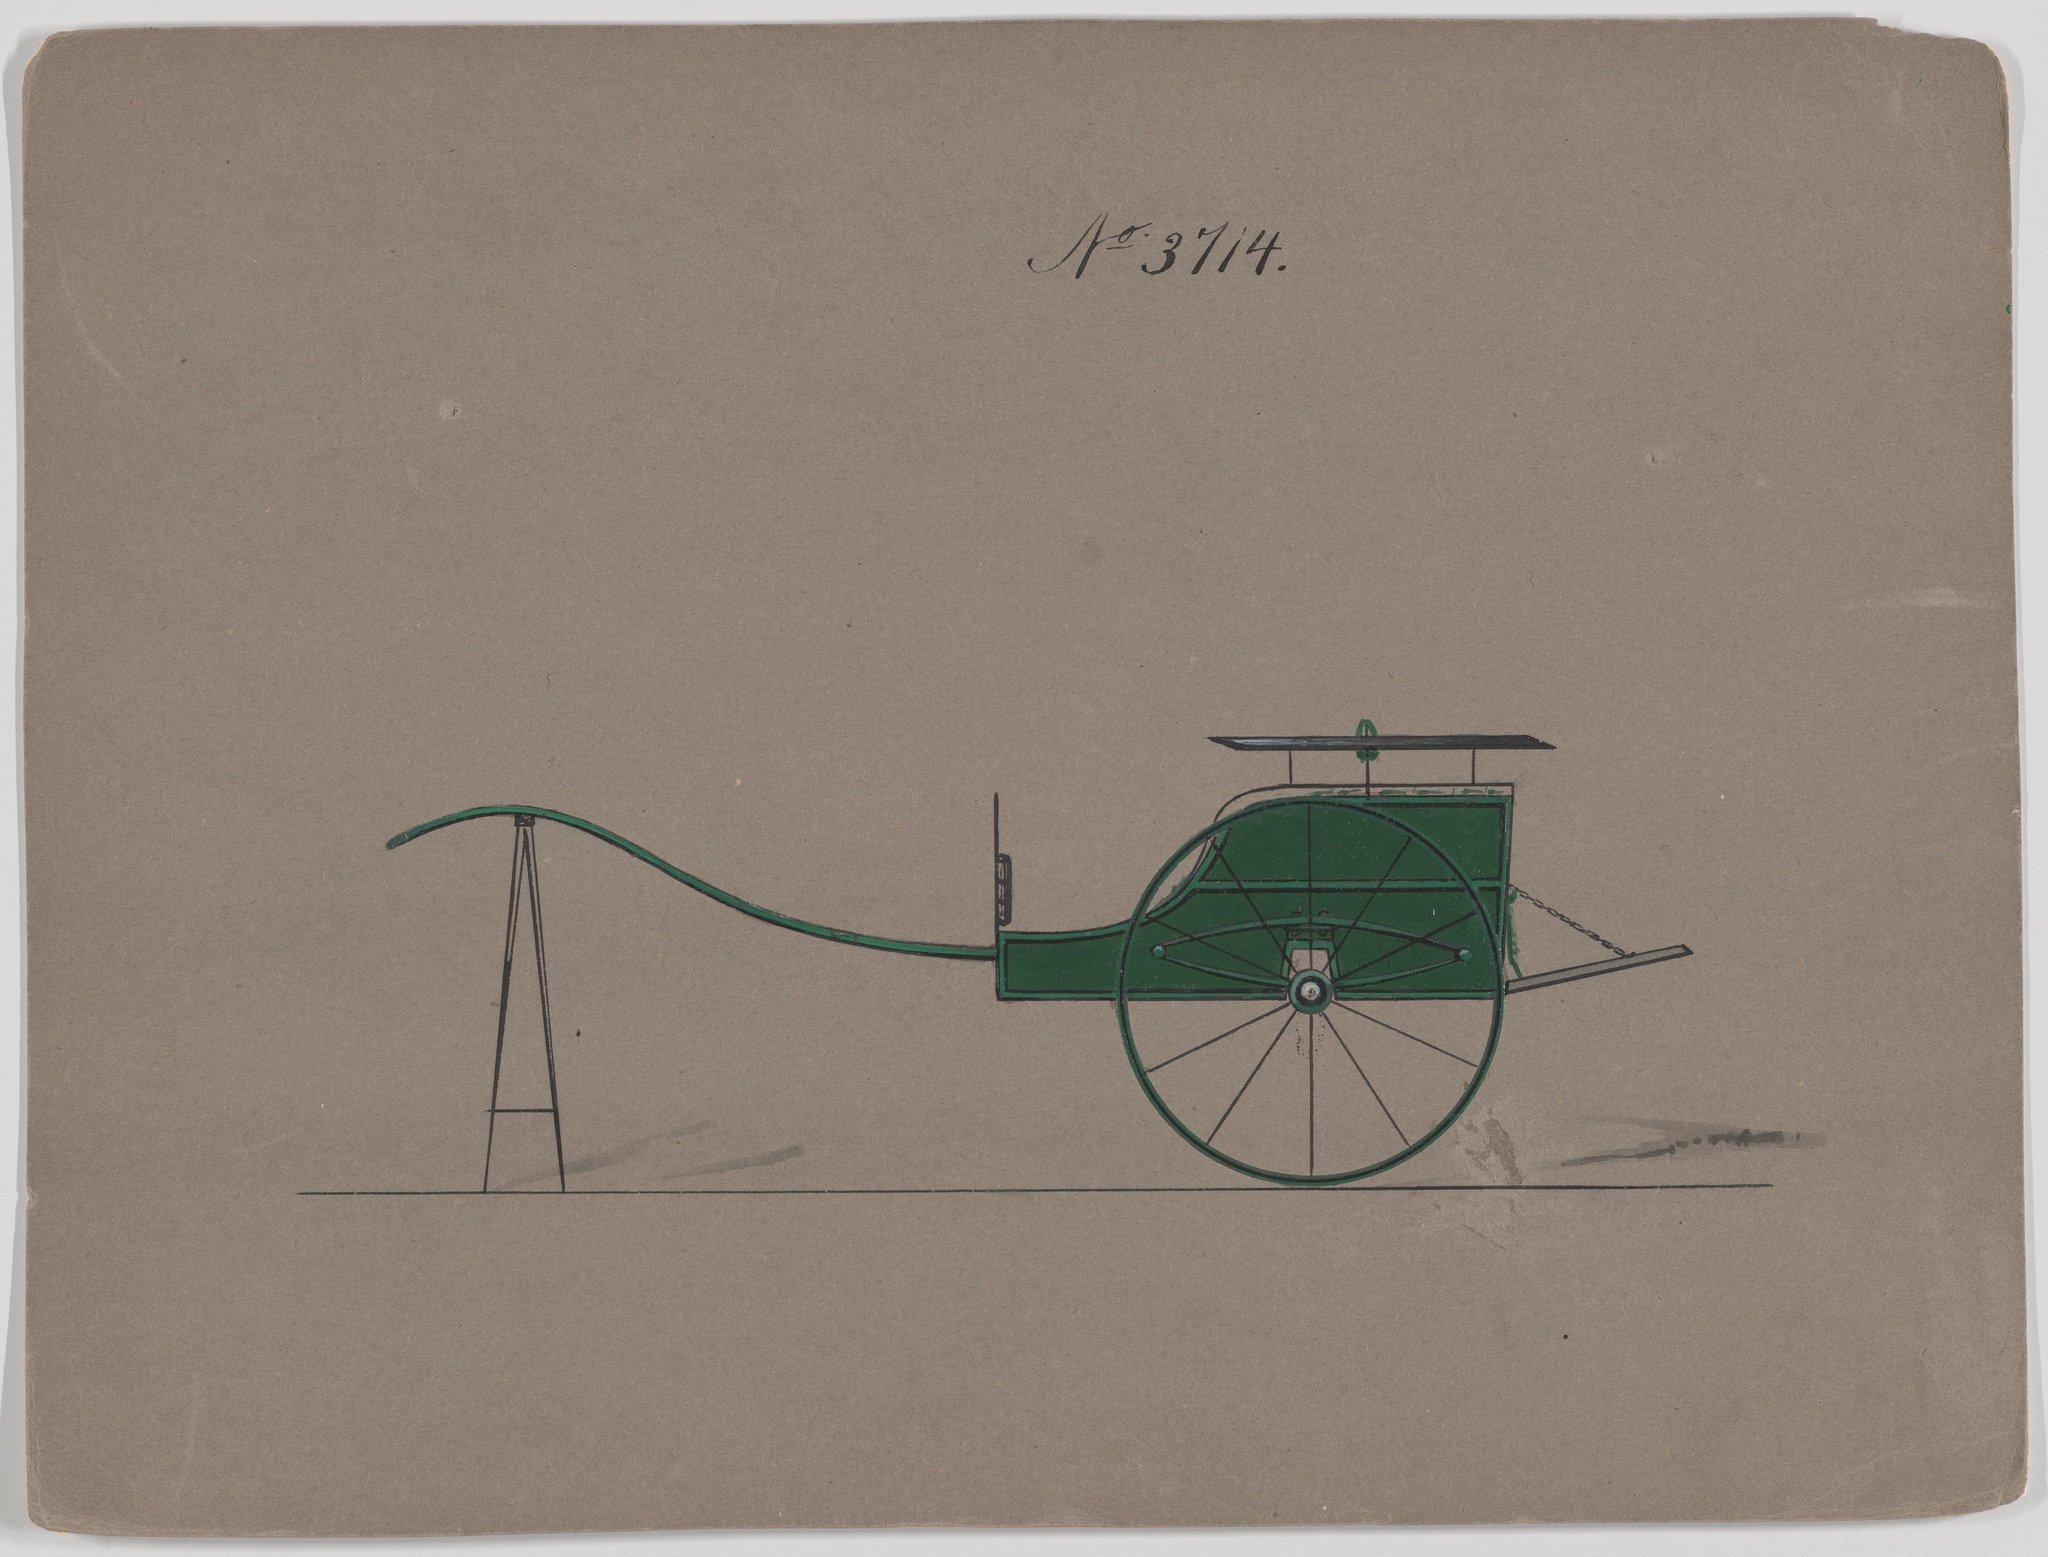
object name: drawing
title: Cart #3714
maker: brewster & co.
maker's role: manufacturer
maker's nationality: american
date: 1881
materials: gouache, gum arabic, ink, watercolor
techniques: pen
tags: carriages